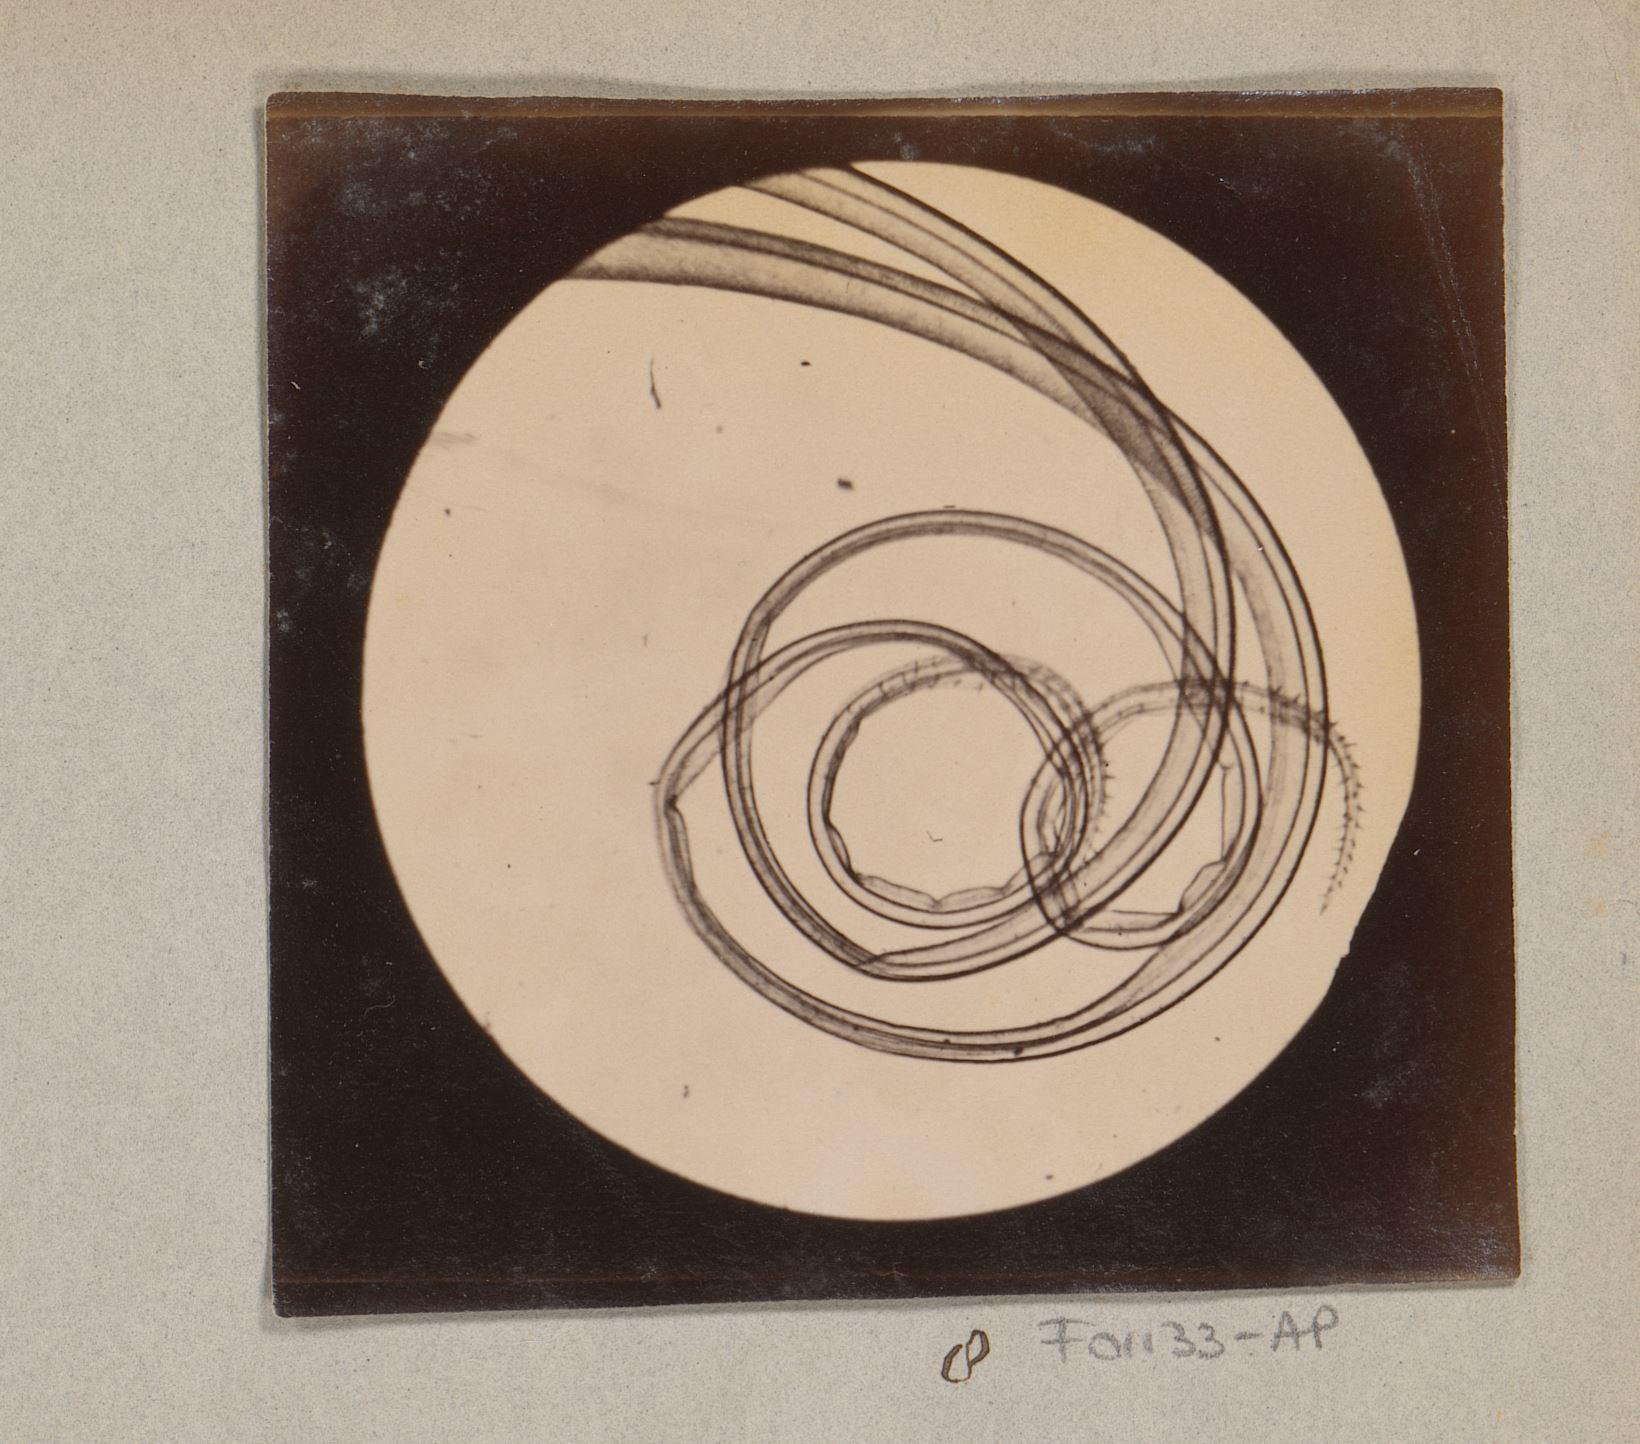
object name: photograph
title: Microscopische opname van voelspriet van een nachtvlinder, dertig keer vergroot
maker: marinus pieter filbri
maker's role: instrument maker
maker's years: 1852-1917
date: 1887-1888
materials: paper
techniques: albumen print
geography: netherlands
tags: insects: moth, netherlands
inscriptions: number: ‘8’, inscription: ‘No. 8. Benaming Voelhoorn id., 30 x vergroot, pose 3 min. Bemerking Beernaer’